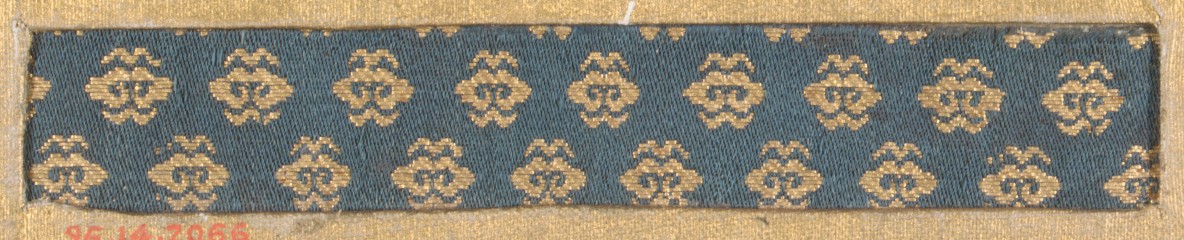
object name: piece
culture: japanese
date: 1701-1900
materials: silk